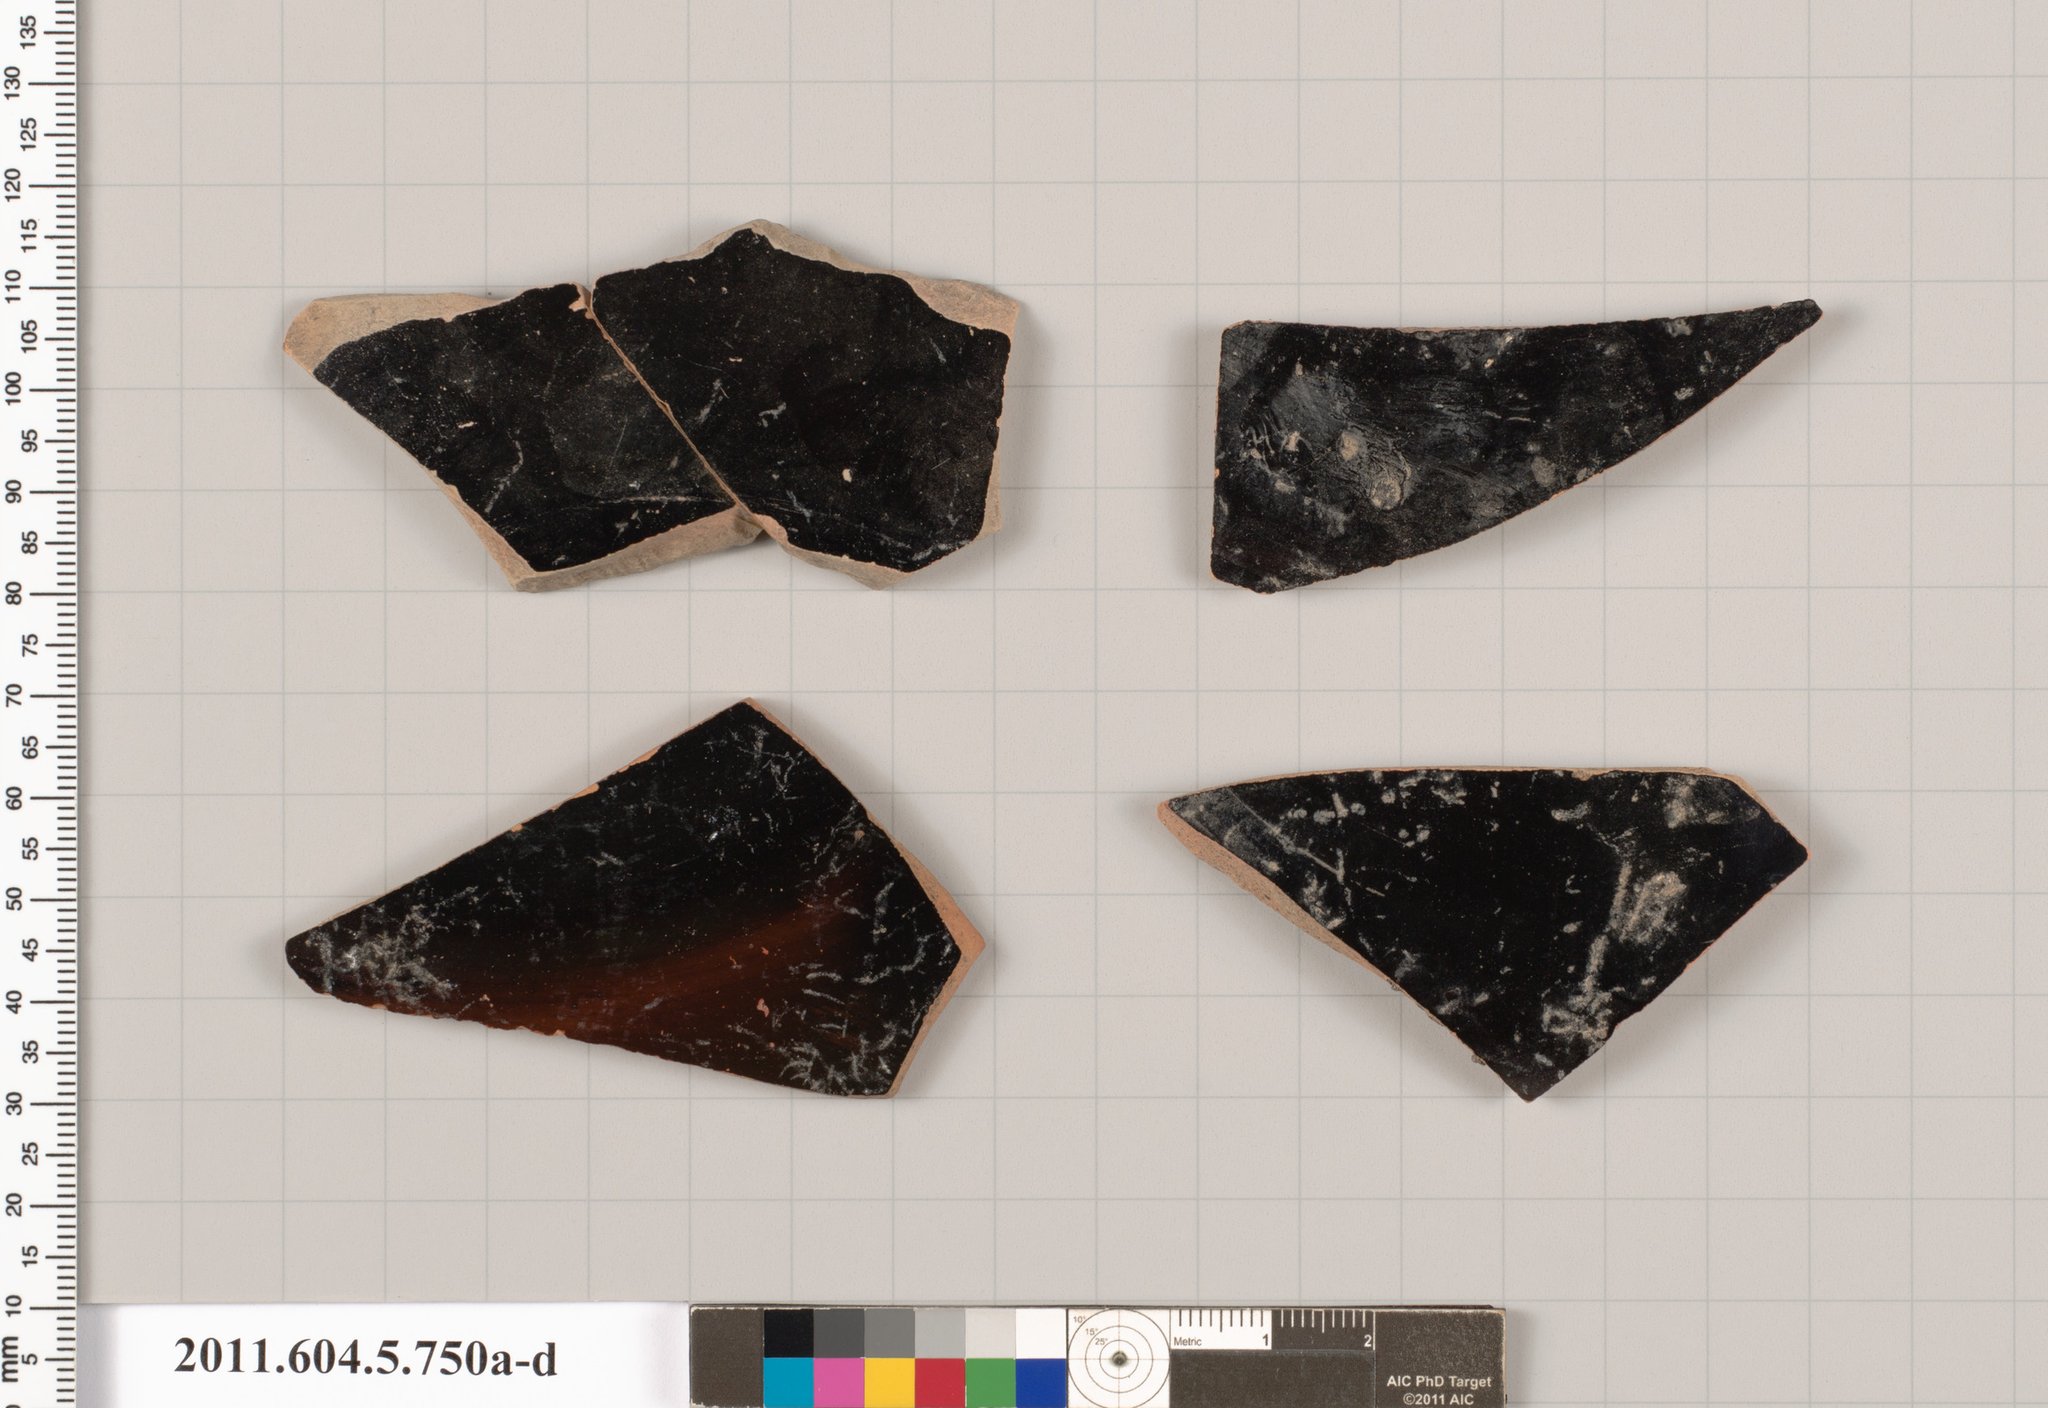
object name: kylix fragment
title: Terracotta fragments of kylikes (drinking cups)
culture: greek, attic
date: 600-401 BCE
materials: terracotta